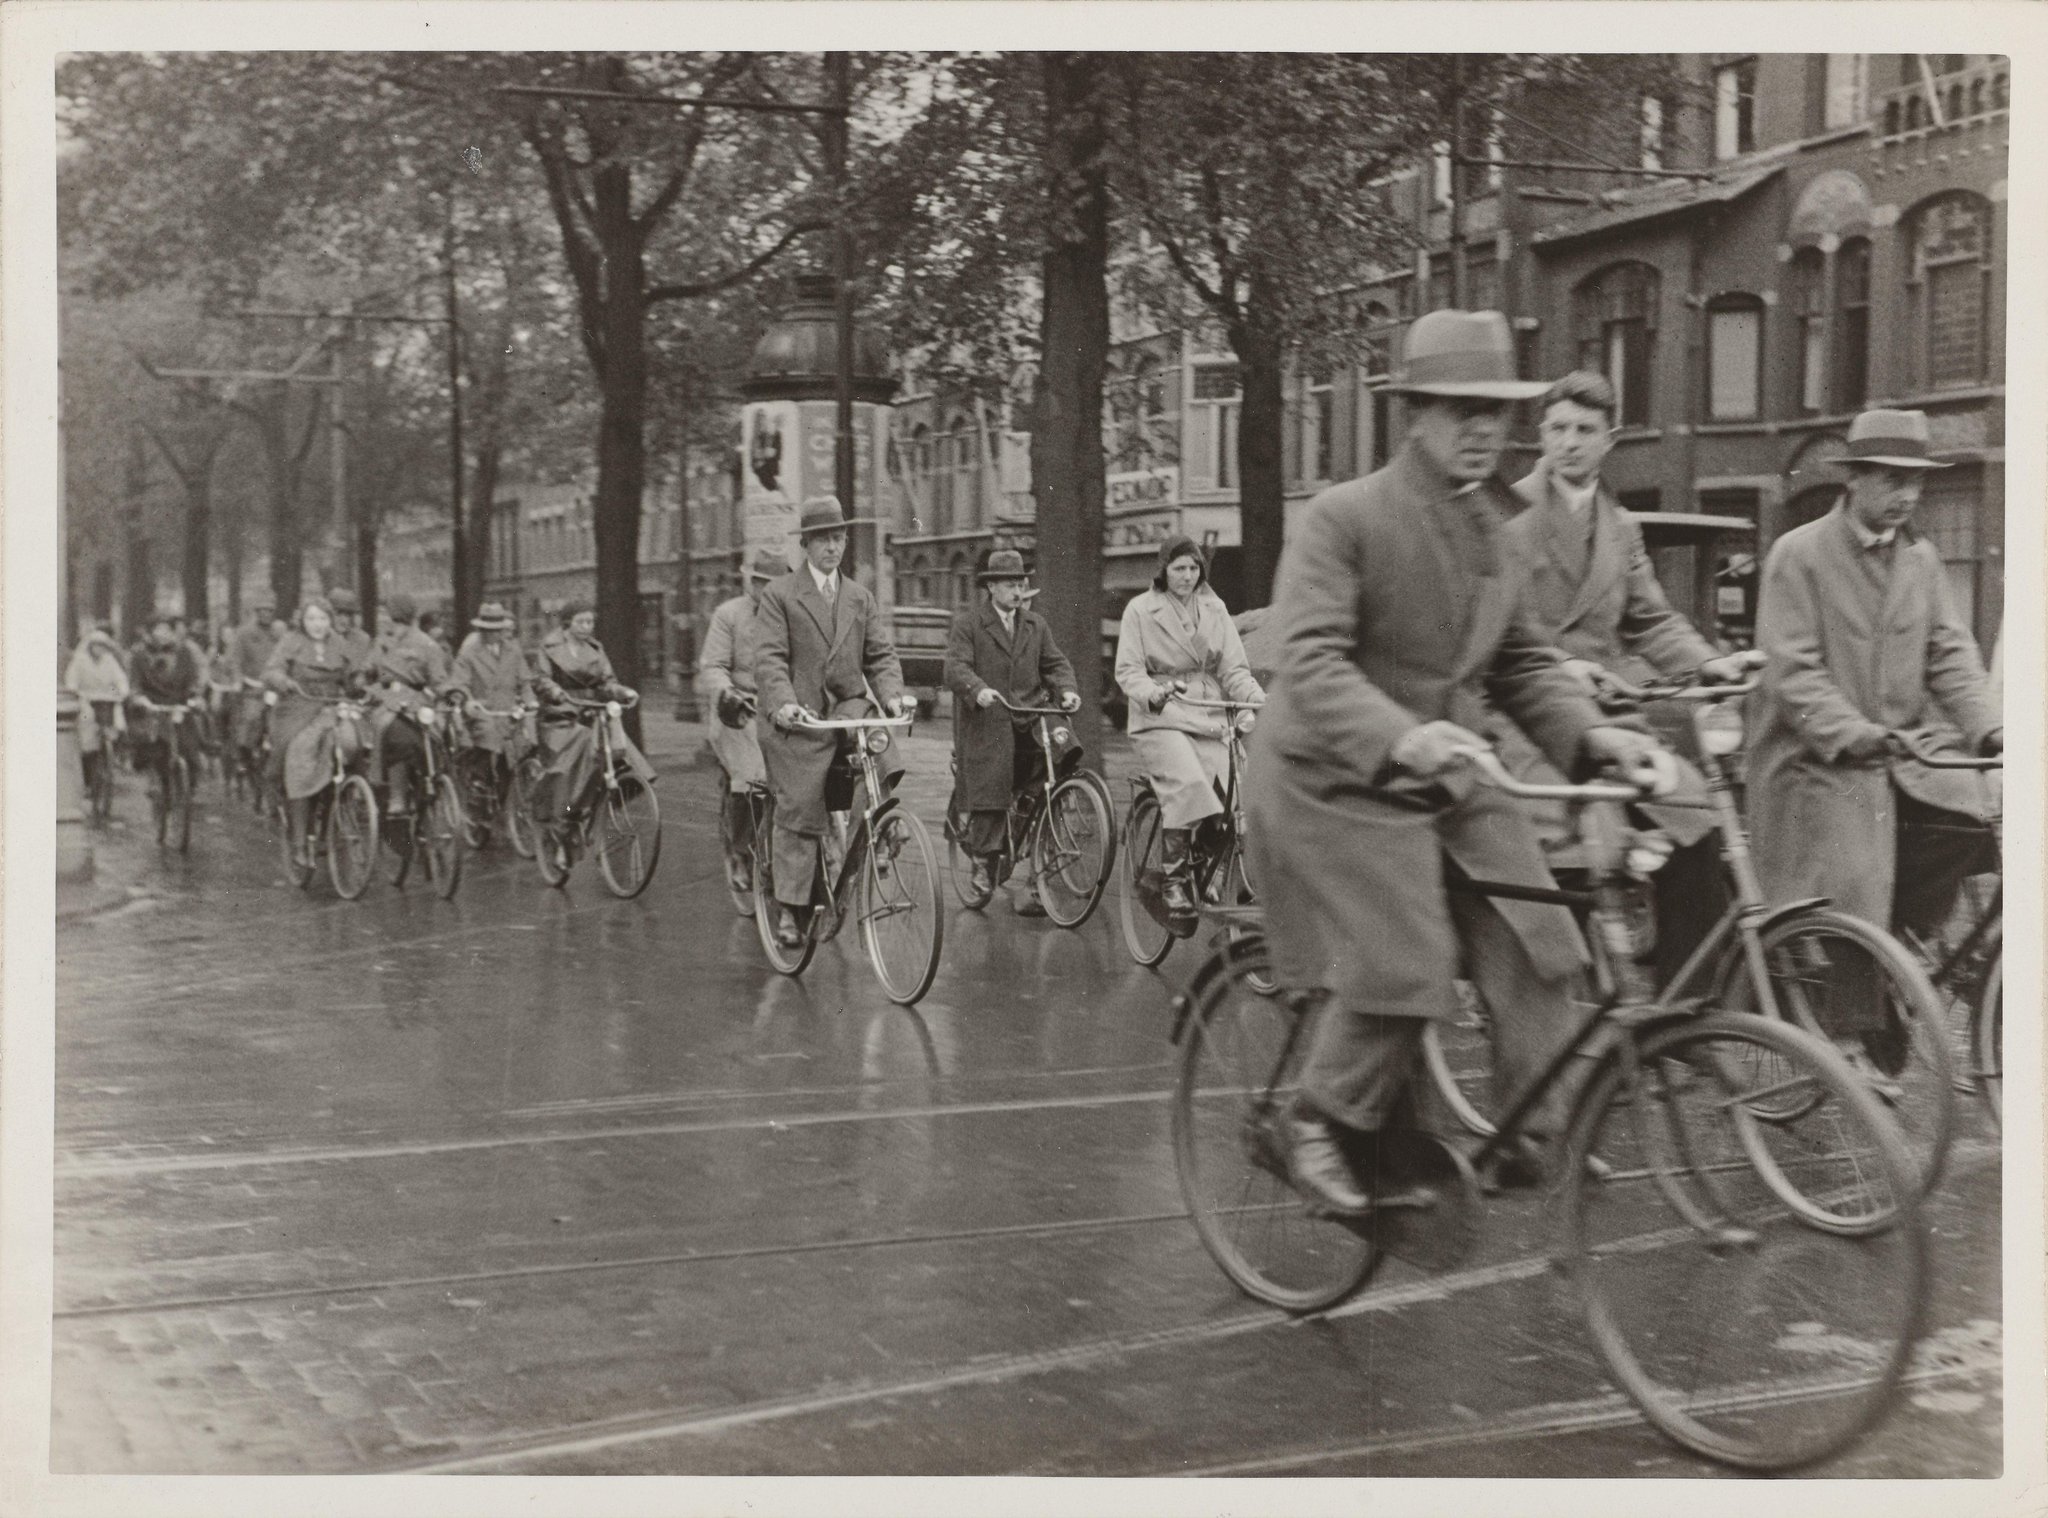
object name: photograph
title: Fietsers in Den Haag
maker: Anonymous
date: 1945-1970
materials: photographic support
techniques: gelatin silver print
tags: bicycle, the hague